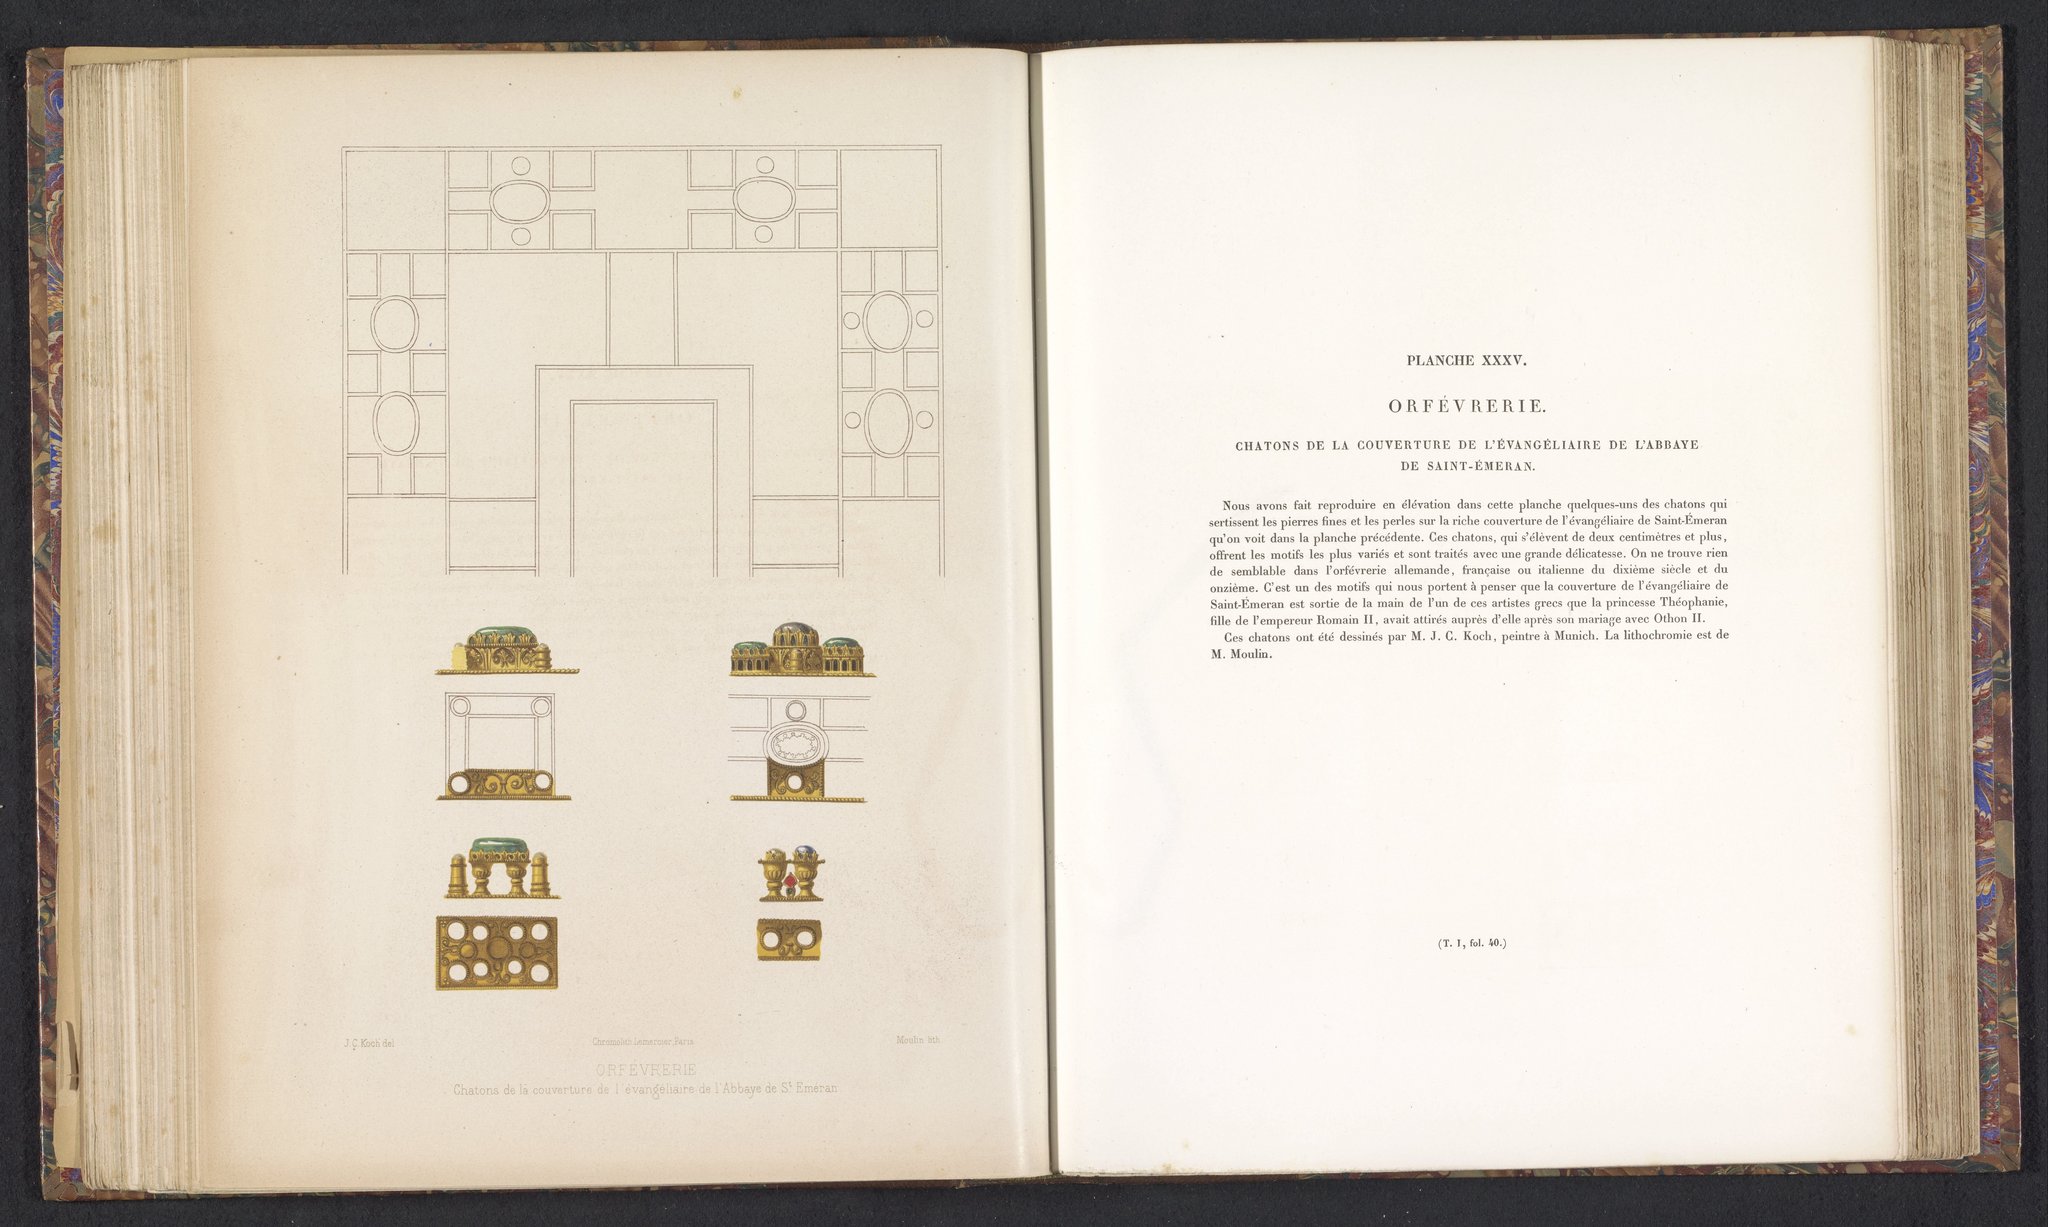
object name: page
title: Chatons de la couverture de l'évangéliaire de l'Abbaye de St. Eméran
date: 1859-1864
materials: paper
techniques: chromolithography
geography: paris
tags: book-cover, binding, gem, gemstone